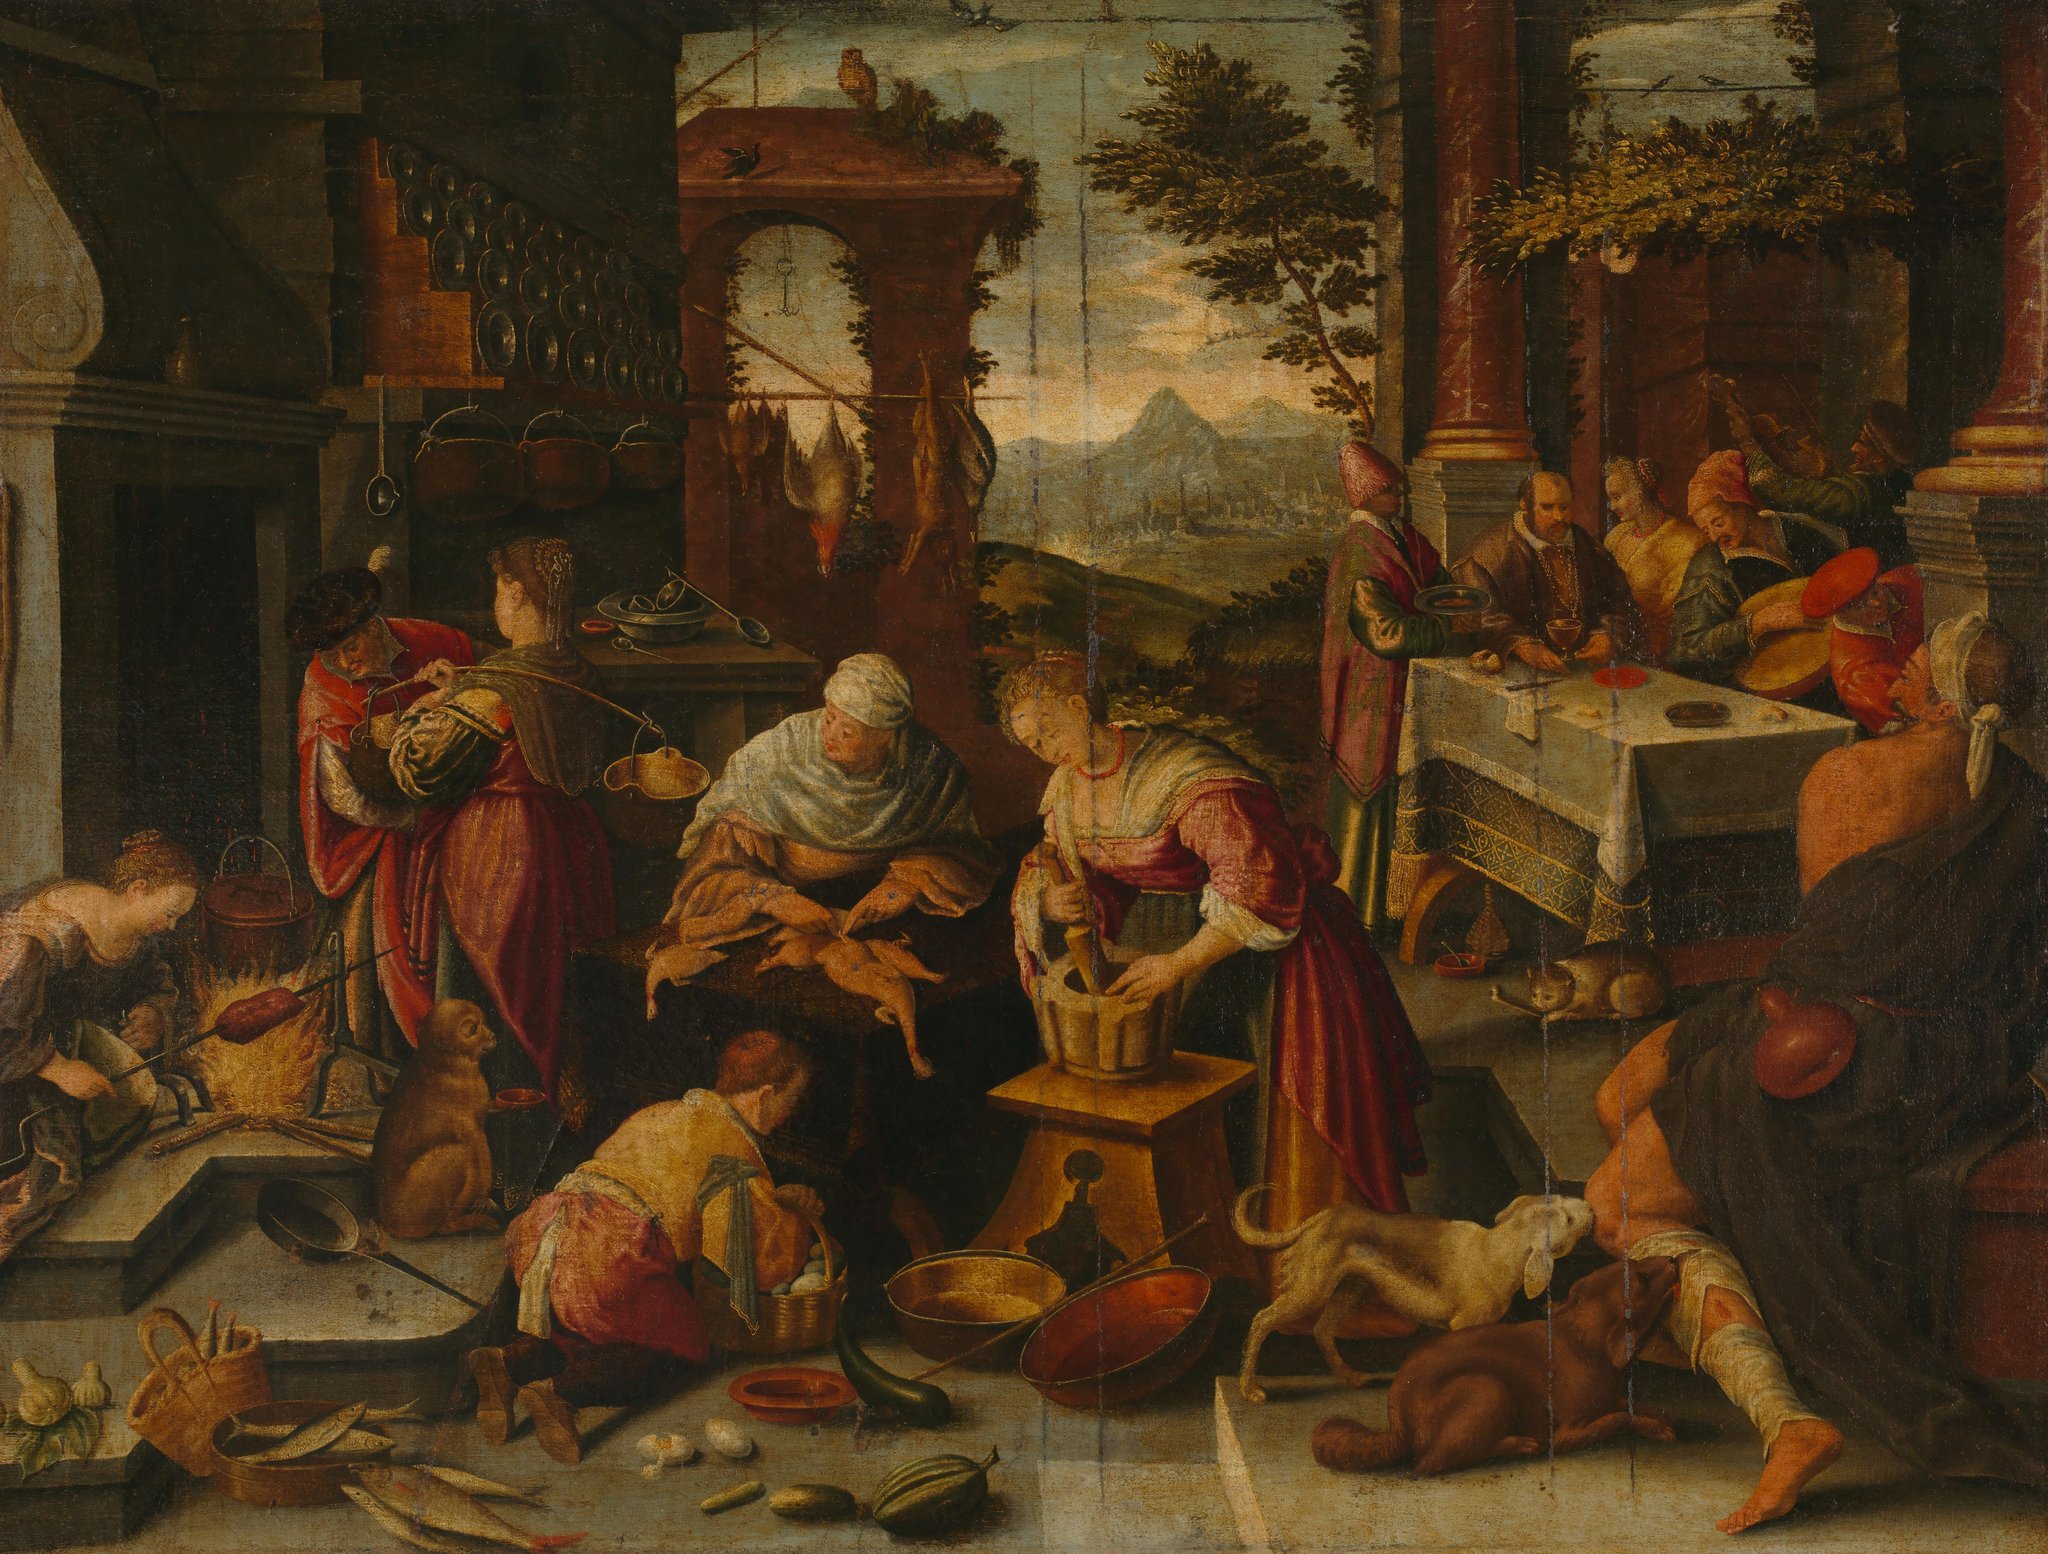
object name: painting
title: Lazarus and the Rich Man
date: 1544-1700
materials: canvas, oil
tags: the rich man (dives) is feasting, while poor lazarus is starving at the gate (dogs licking lazarus' sores) (luke 16:19-31)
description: De rijke man en de arme Lazarus. Het verhaal wordt verbeeld in een keuken waar een maaltijd wordt voorbereid. Rechts likken honden de wonden van de bedelaar Lazarus. Hierachter de rijkaard aan tafel waar muzikanten spelen. In de keuken kijkt een aap toe hoe een kip wordt geplukt, in het midden werkt een vrouw met een vijzel. Op de voorgrond liggen vissen, eieren en groenten. Het schilderij is verwant aan een prent van Johannes Sadeler I, naar een schilderij van Bassano.